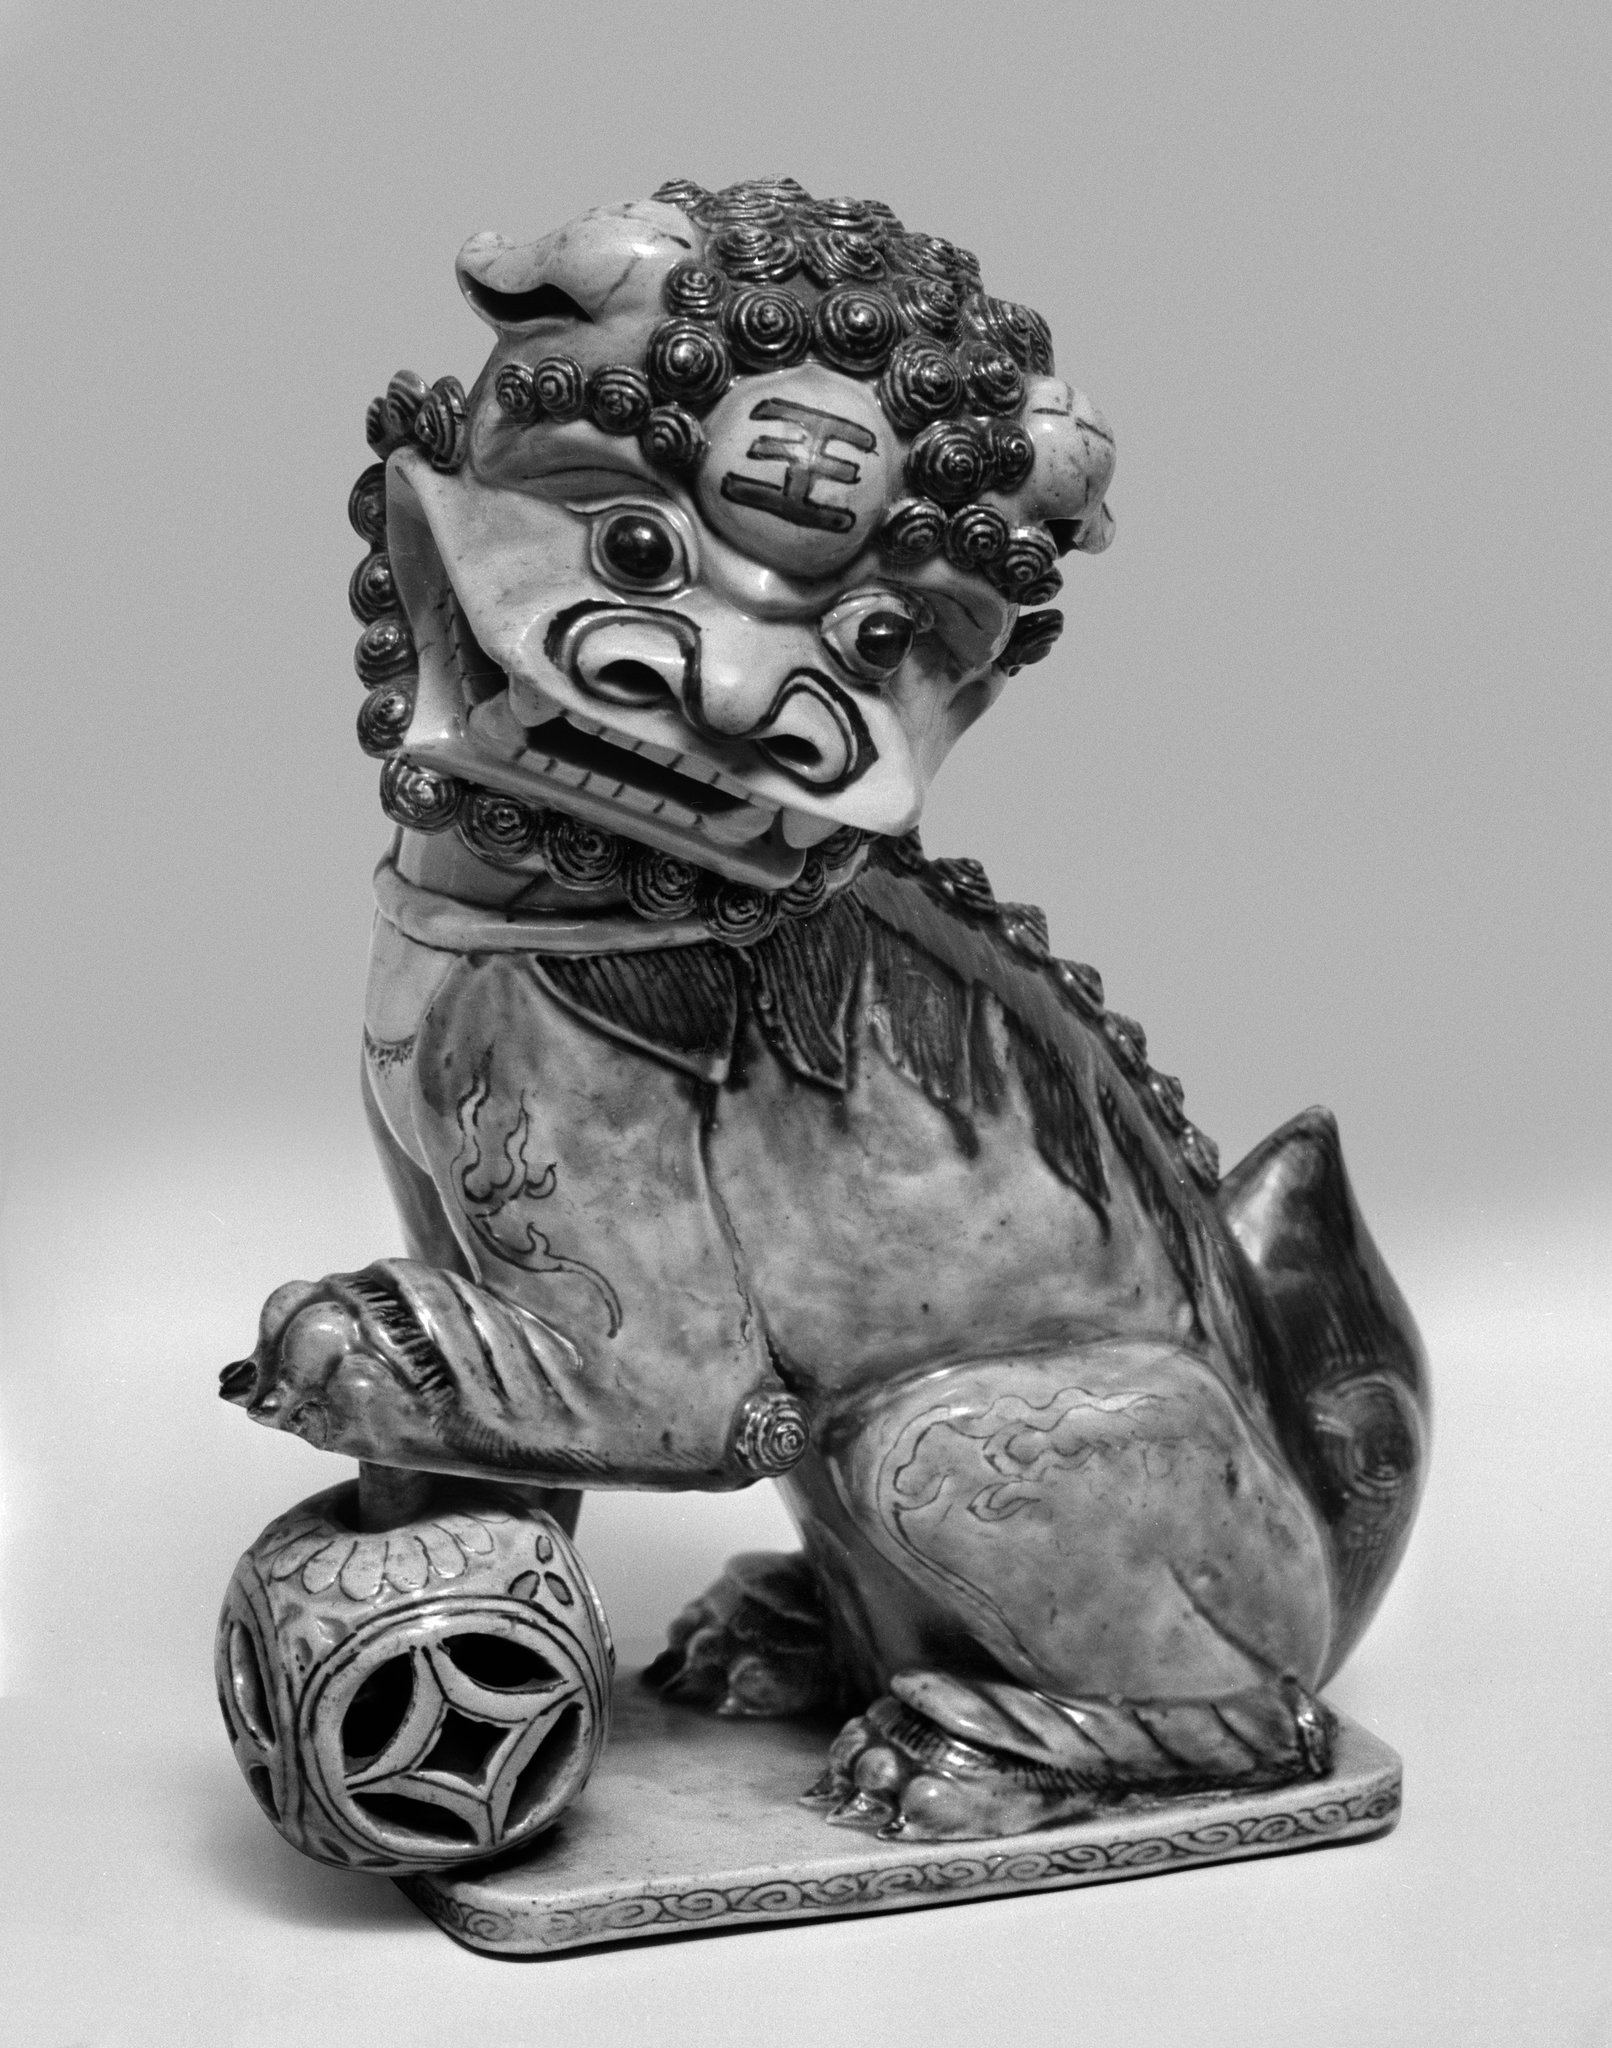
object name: figure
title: Figure of a Lion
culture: chinese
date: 1662-1722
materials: biscuit, enamel, porcelain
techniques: polychrome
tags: lions